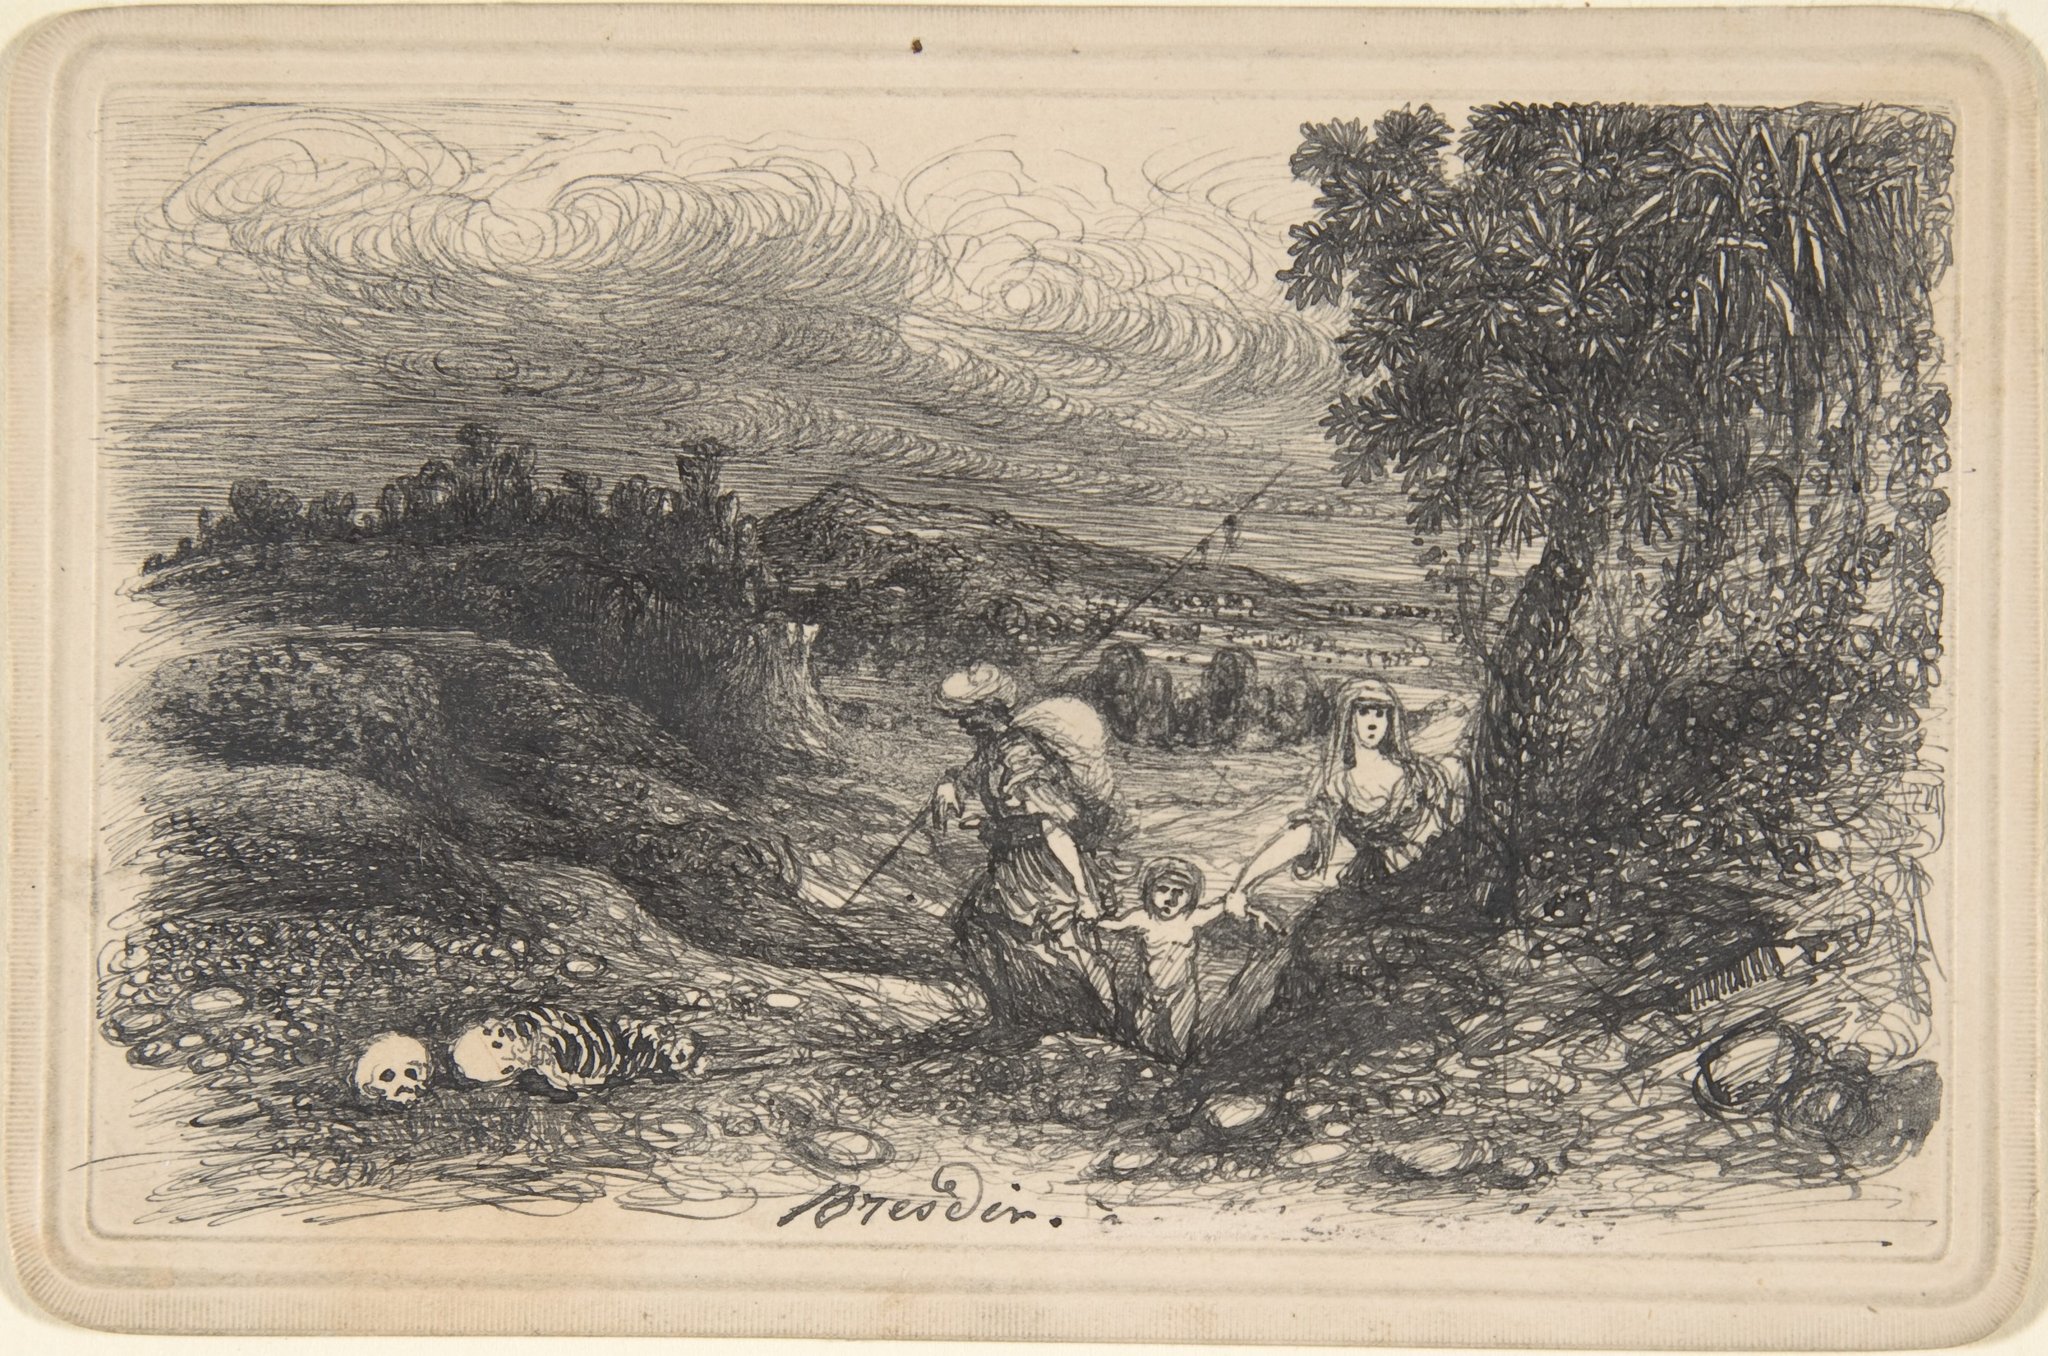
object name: drawing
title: Flight to Egypt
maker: rodolphe bresdin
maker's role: artist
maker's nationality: french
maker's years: 1822-1885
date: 1840-1885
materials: ink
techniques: embossing, pen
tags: skeletons,boys,men,women,trees